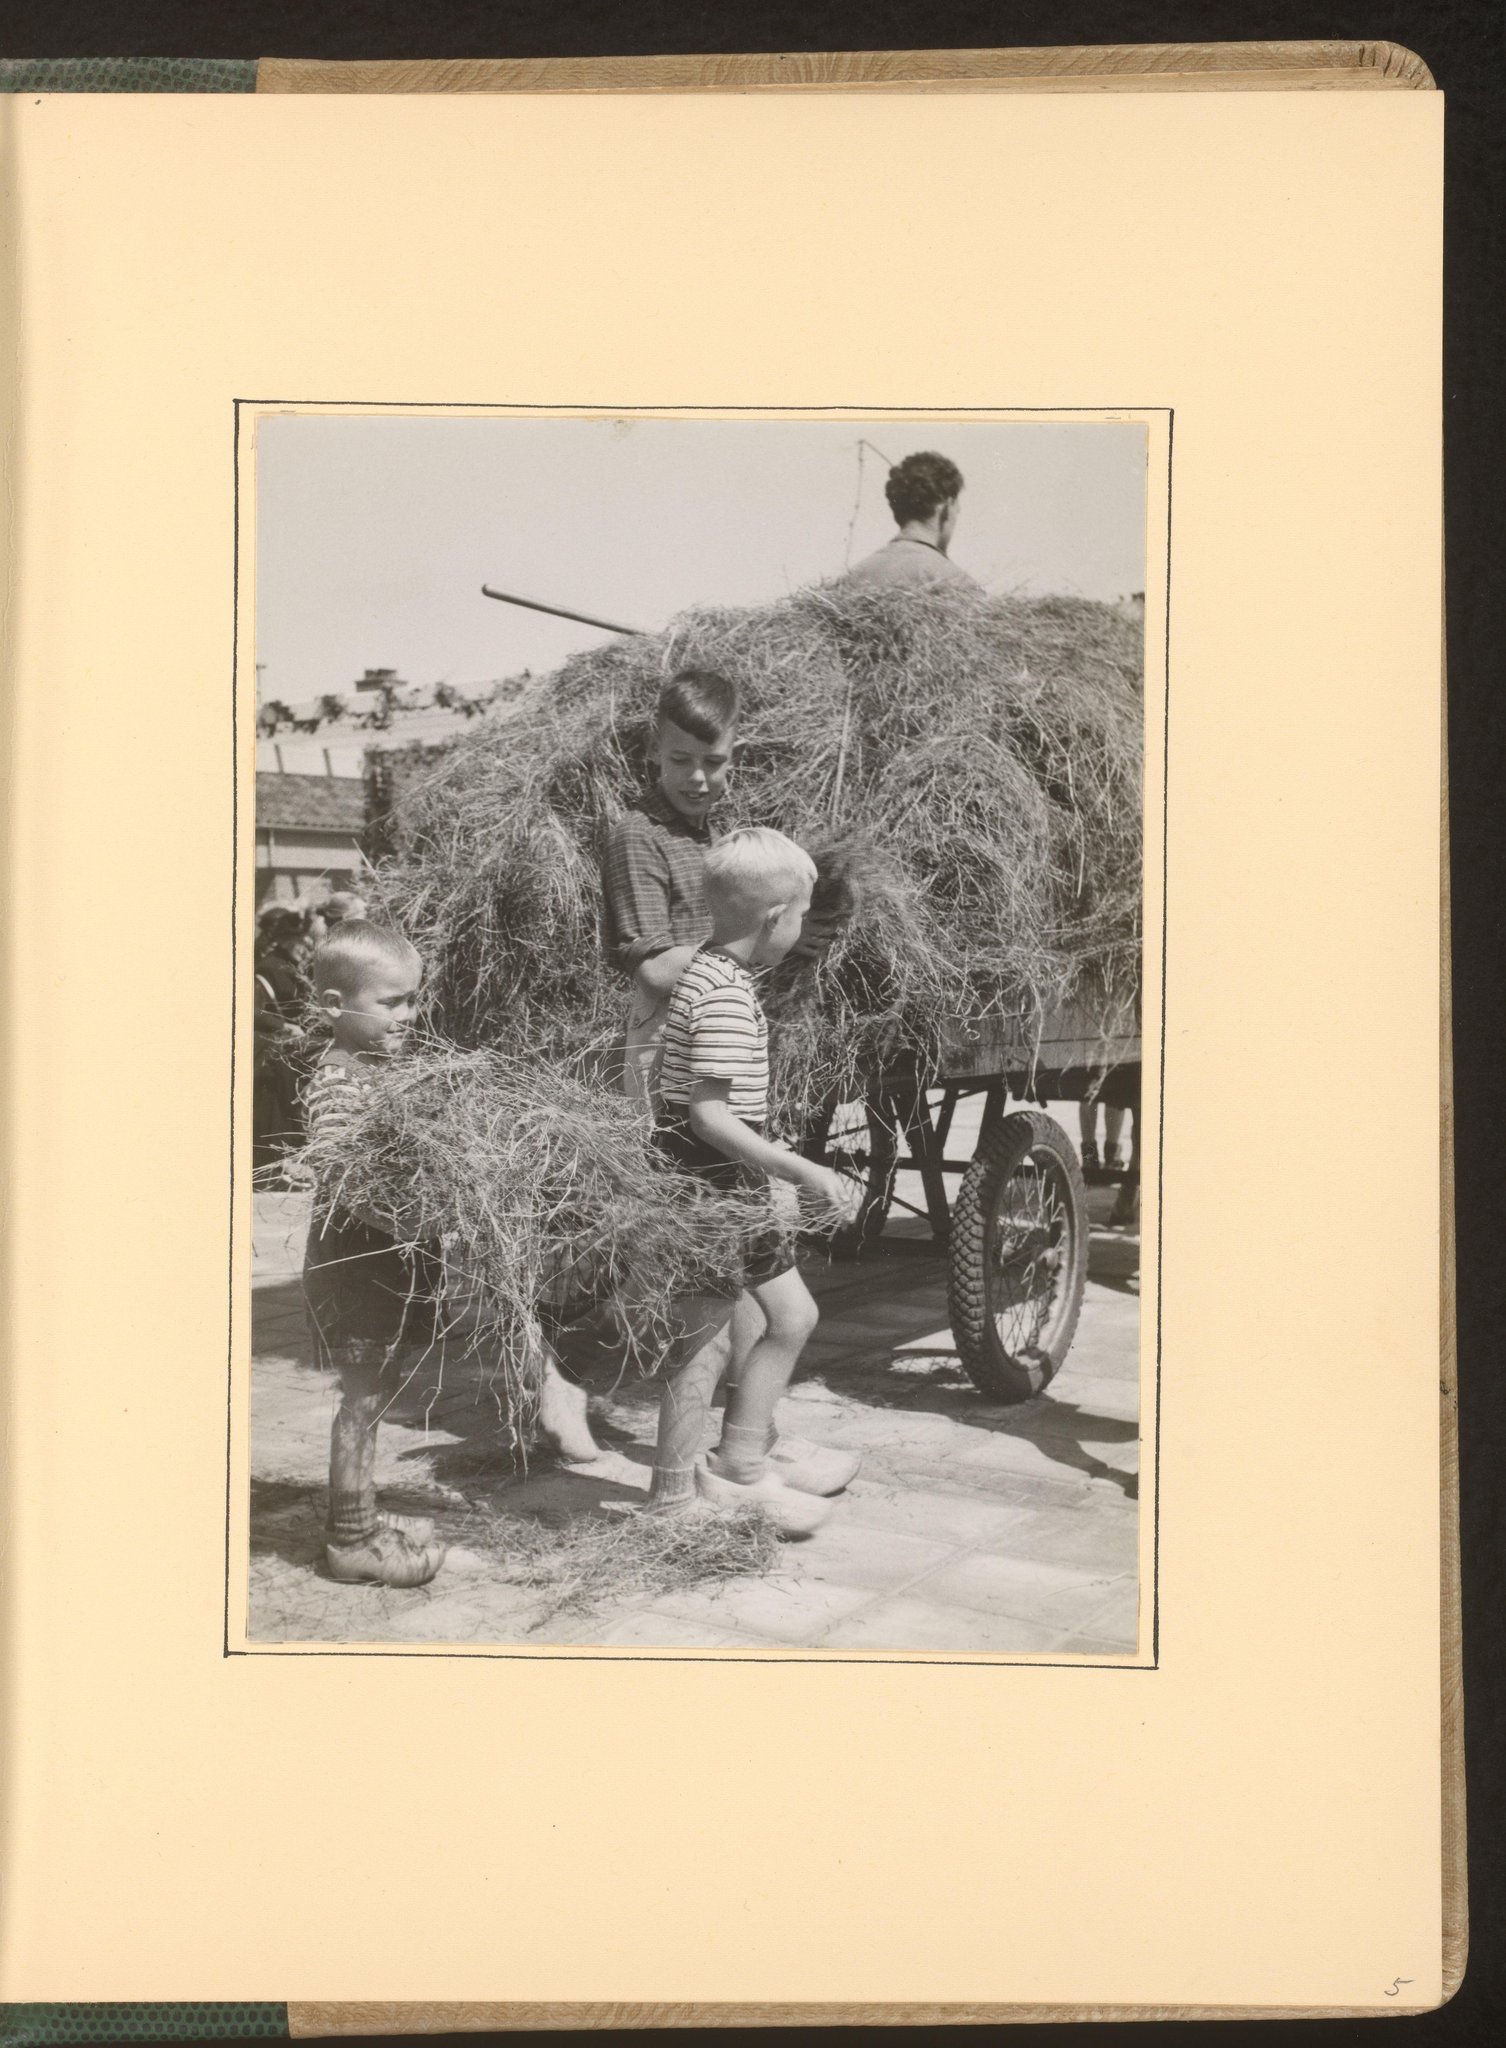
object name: photograph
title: De Lochemse Hooiplukkers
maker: Anonymous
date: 1953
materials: paper, photographic support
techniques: gelatin silver print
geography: lochem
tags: the hague, willem drees, prime minister, hay-wagon, old-people's home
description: Optreden van Lochemse kinderen die hooi laden op een hooiwagen. Onderdeel van het fotoalbum over de opening van het bejaardenhuis De Berkelhof in Lochem door premier Willem Drees op 8 augustus 1953.